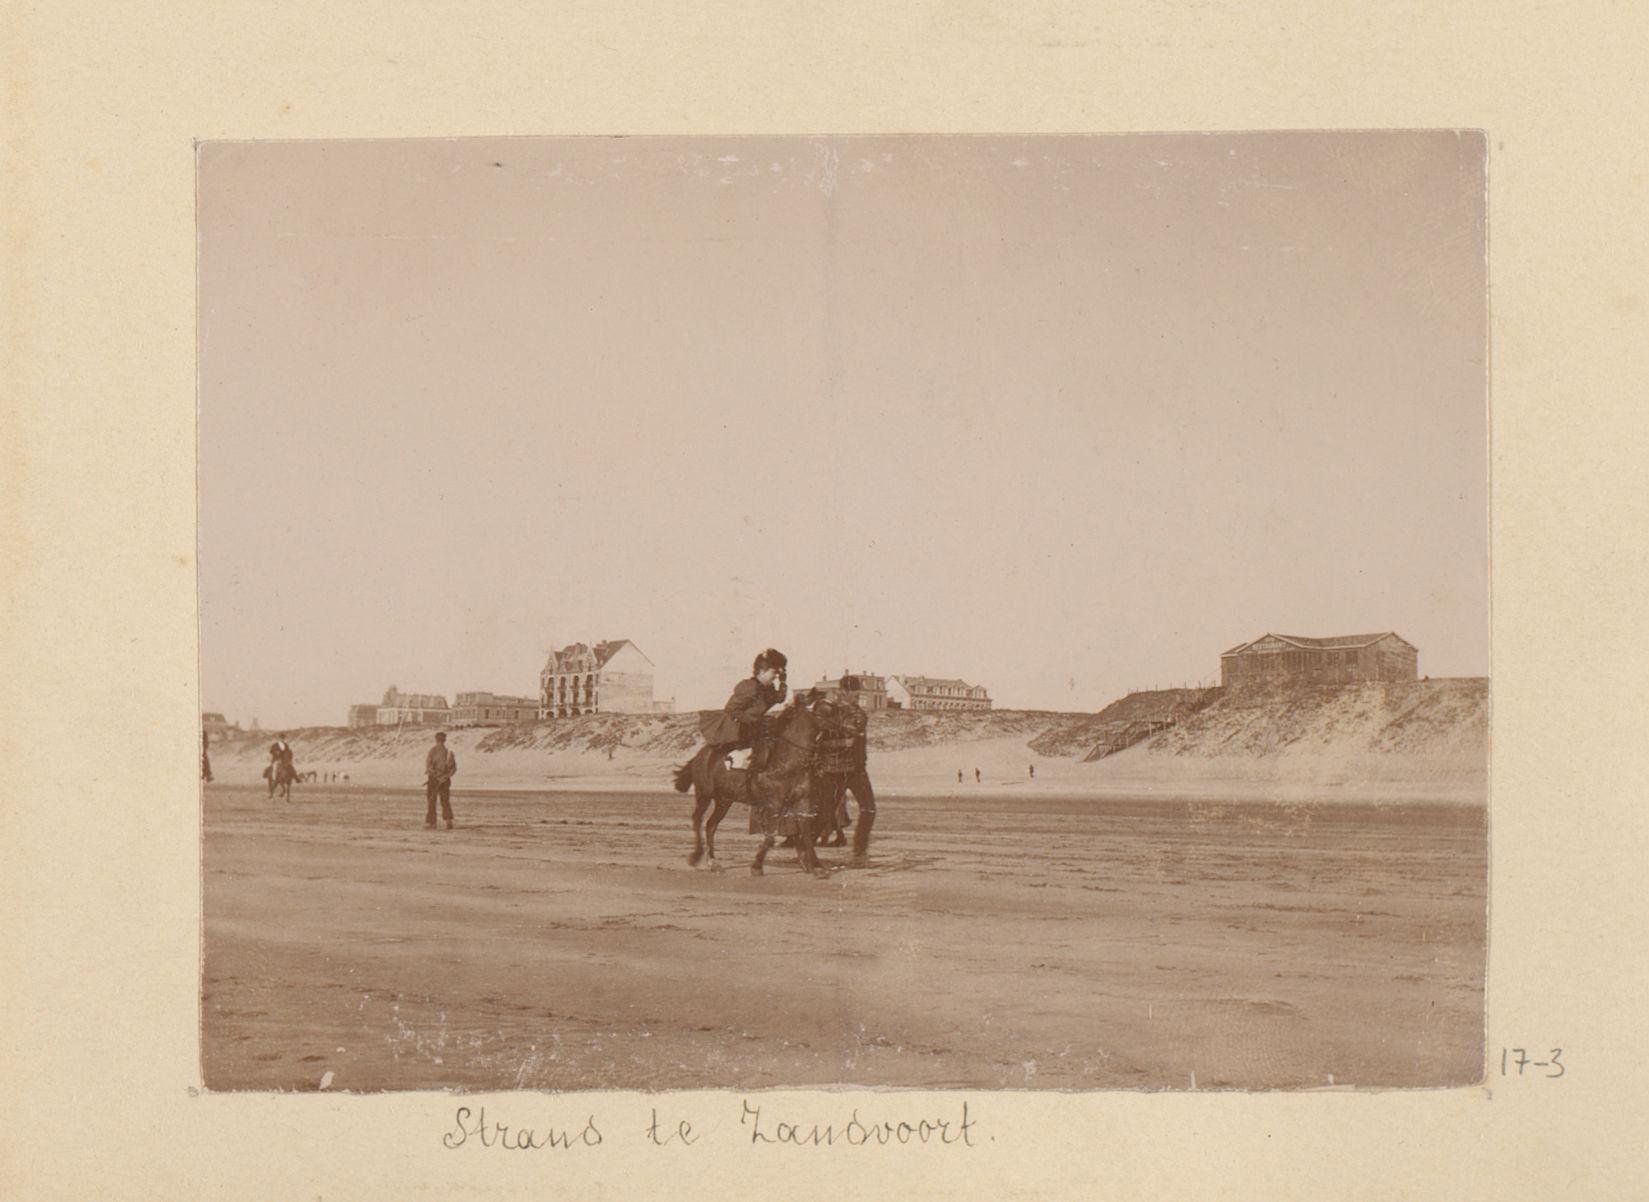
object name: photograph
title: Strand te Zandvoort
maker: hendrik herman van den berg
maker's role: amateurfotograaf, jurist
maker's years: 1875-1944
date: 1890-1894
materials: paper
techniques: collodion silver print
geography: zandvoort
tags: beach (as place of recreation), riding a horse, ass, or mule; rider, horseman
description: Foto 3 op albumblad 17 uit album "Amsterdam 1890-1894".